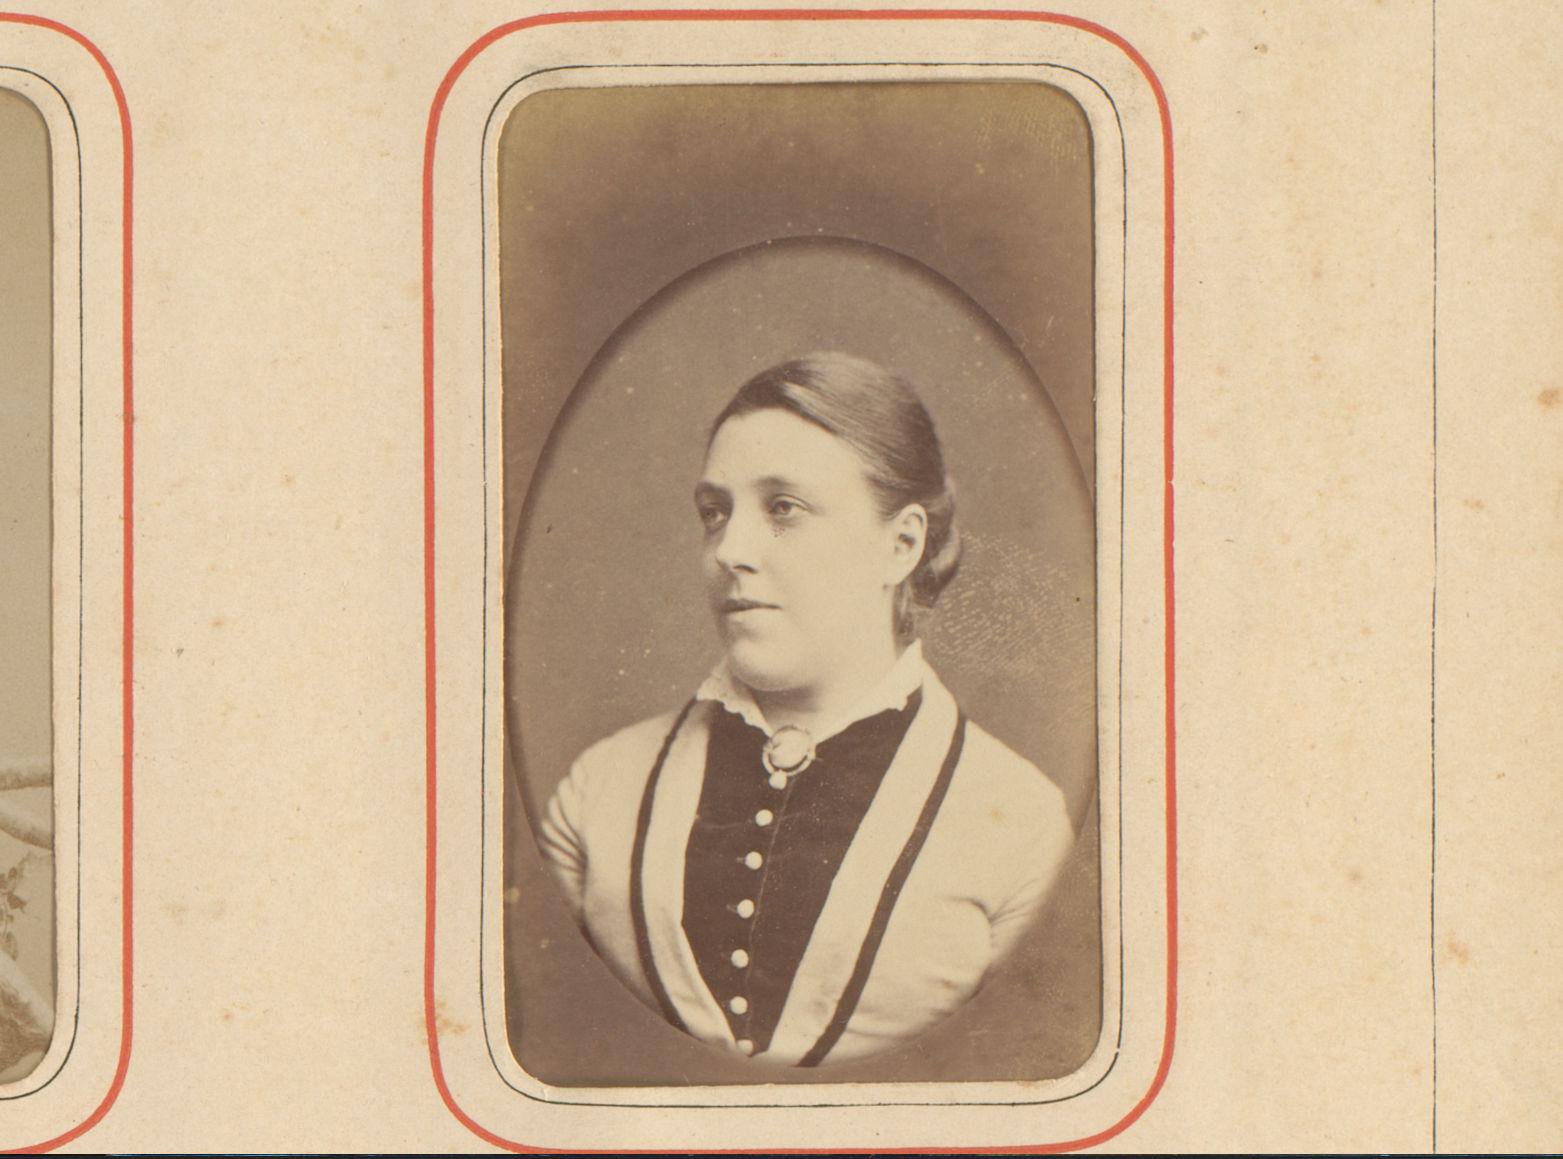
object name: carte de visite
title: Portret van een onbekende vrouw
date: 1870-1890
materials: cardboard, paper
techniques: albumen print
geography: batavia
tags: anonymous historical person portrayed - bb - woman